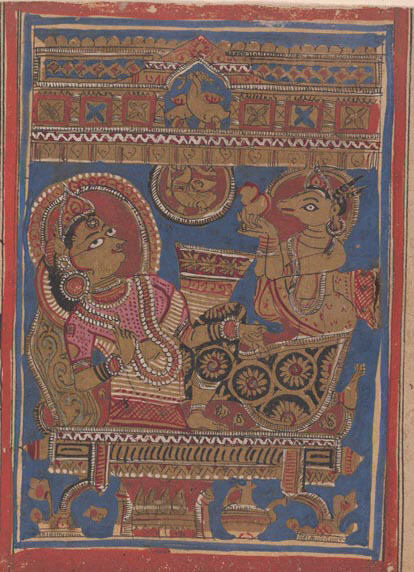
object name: folio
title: Harinaigamesin Brings the Embryo to Queen Trisala: Folio from a Kalpasutra Manuscript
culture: indian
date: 1401-1500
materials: gold, ink, paper, watercolor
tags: queens